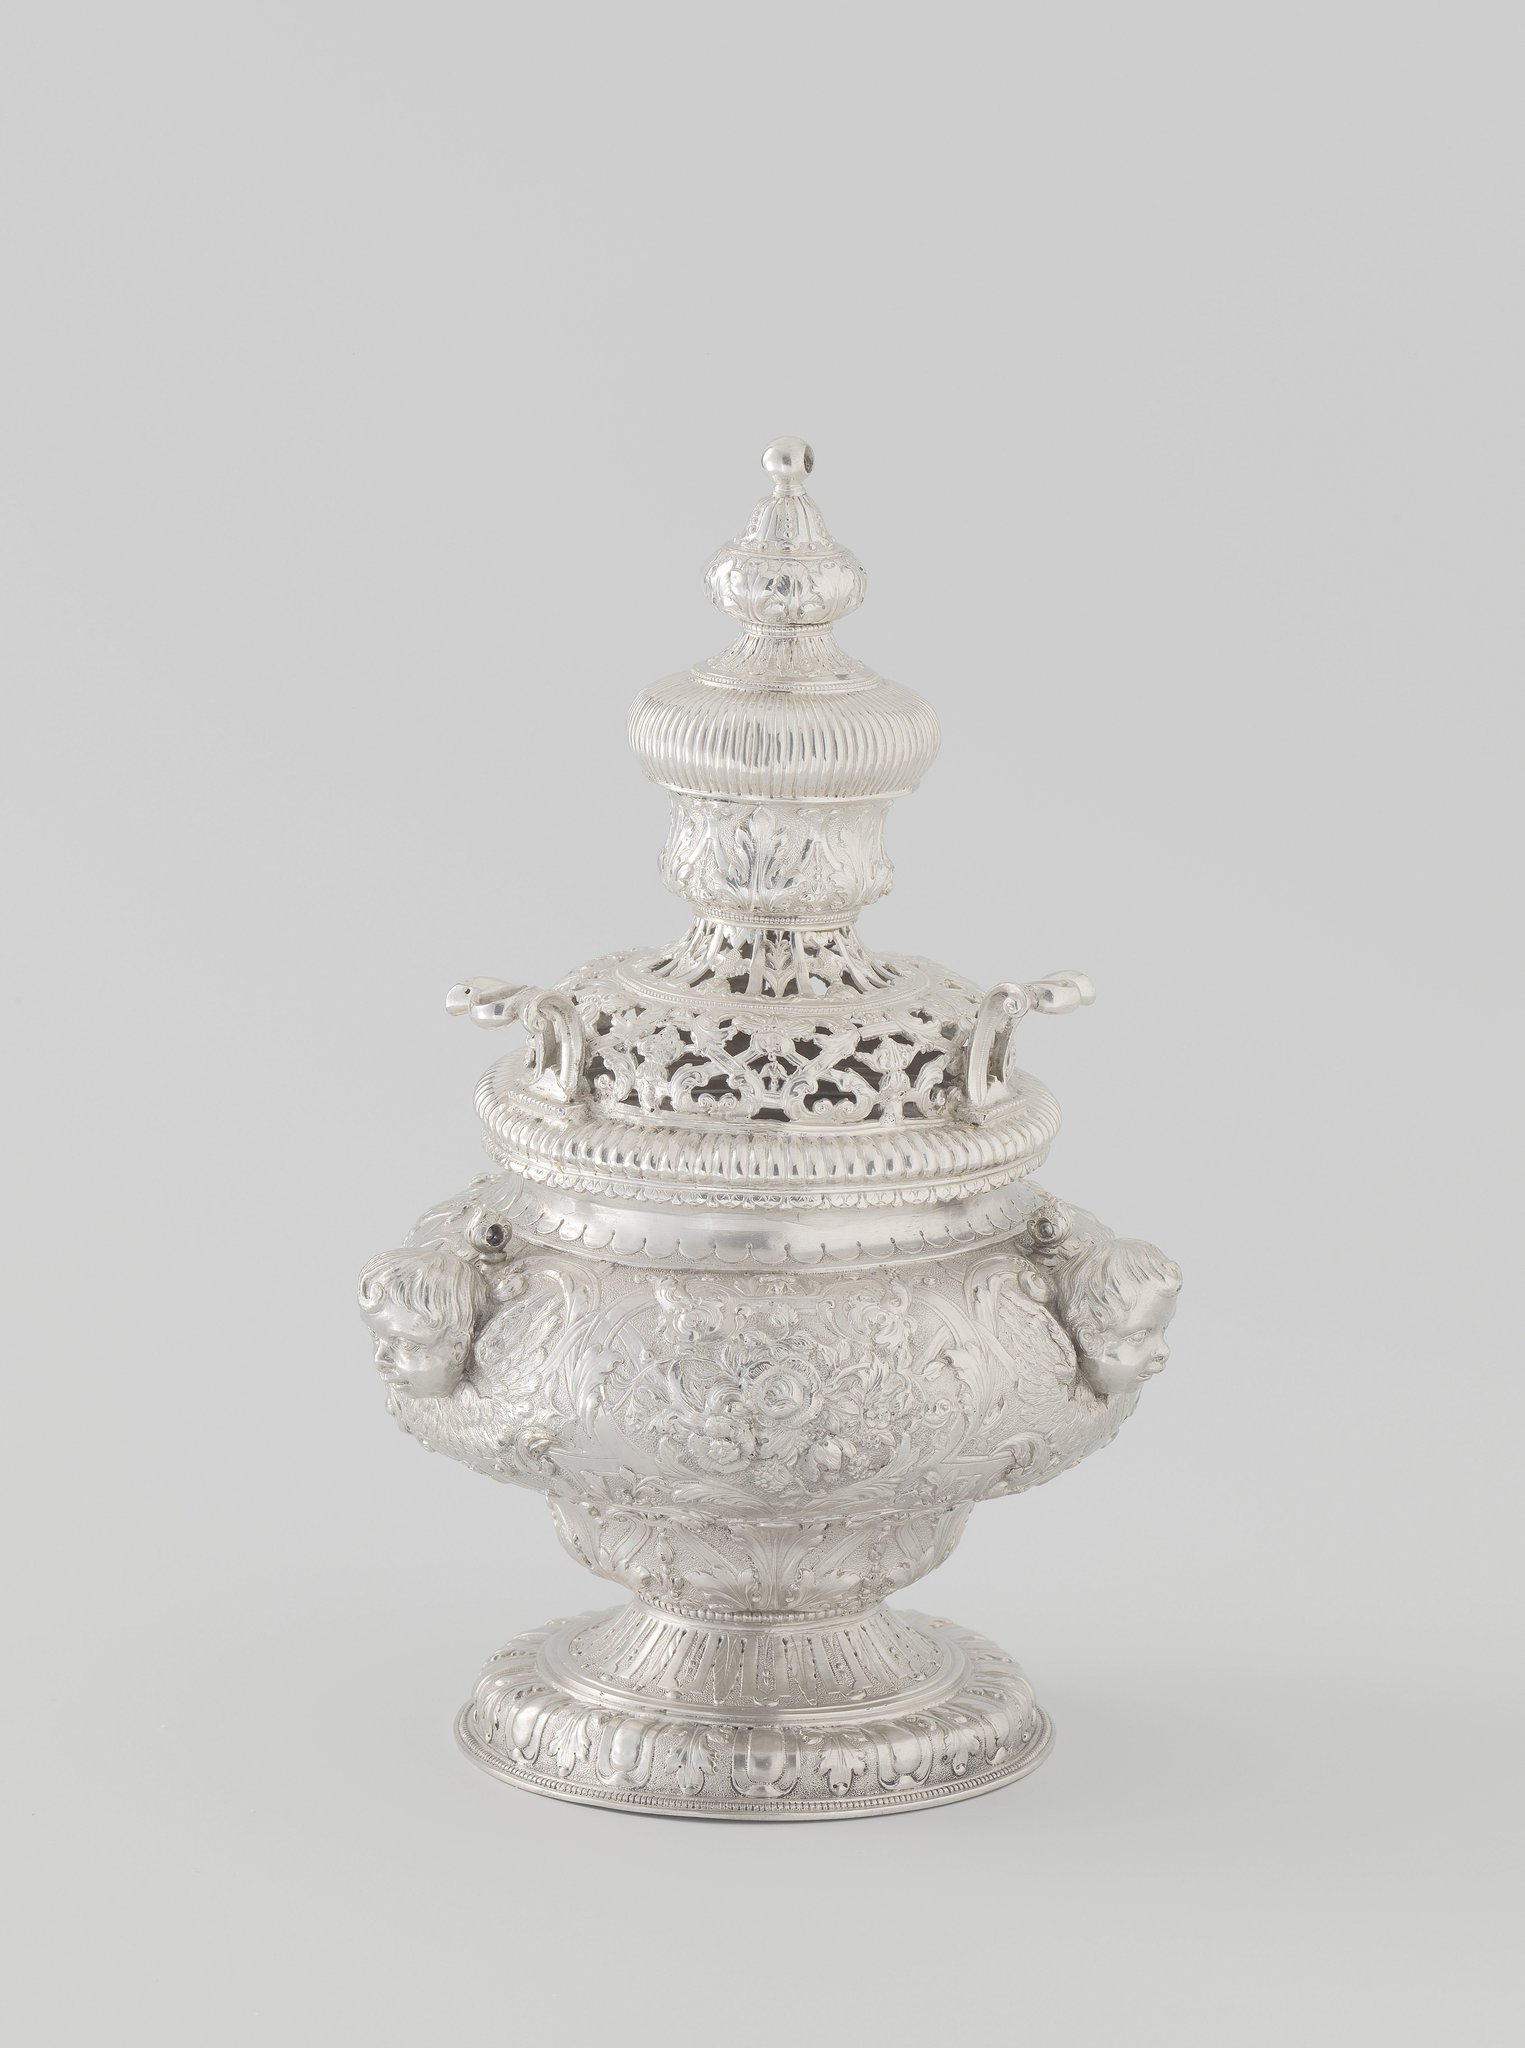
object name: censer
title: Wierookvat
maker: johannes van der lely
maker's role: silversmith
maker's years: 1673-1749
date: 1714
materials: silver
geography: leeuwarden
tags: cherubs, i.e. children's heads with wings, acanthus ~ ornament, bunch of flowers ~ ornament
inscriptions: mark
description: Thurible. Silver. Leeuwarden, 1714, by Johannes van der Lely.